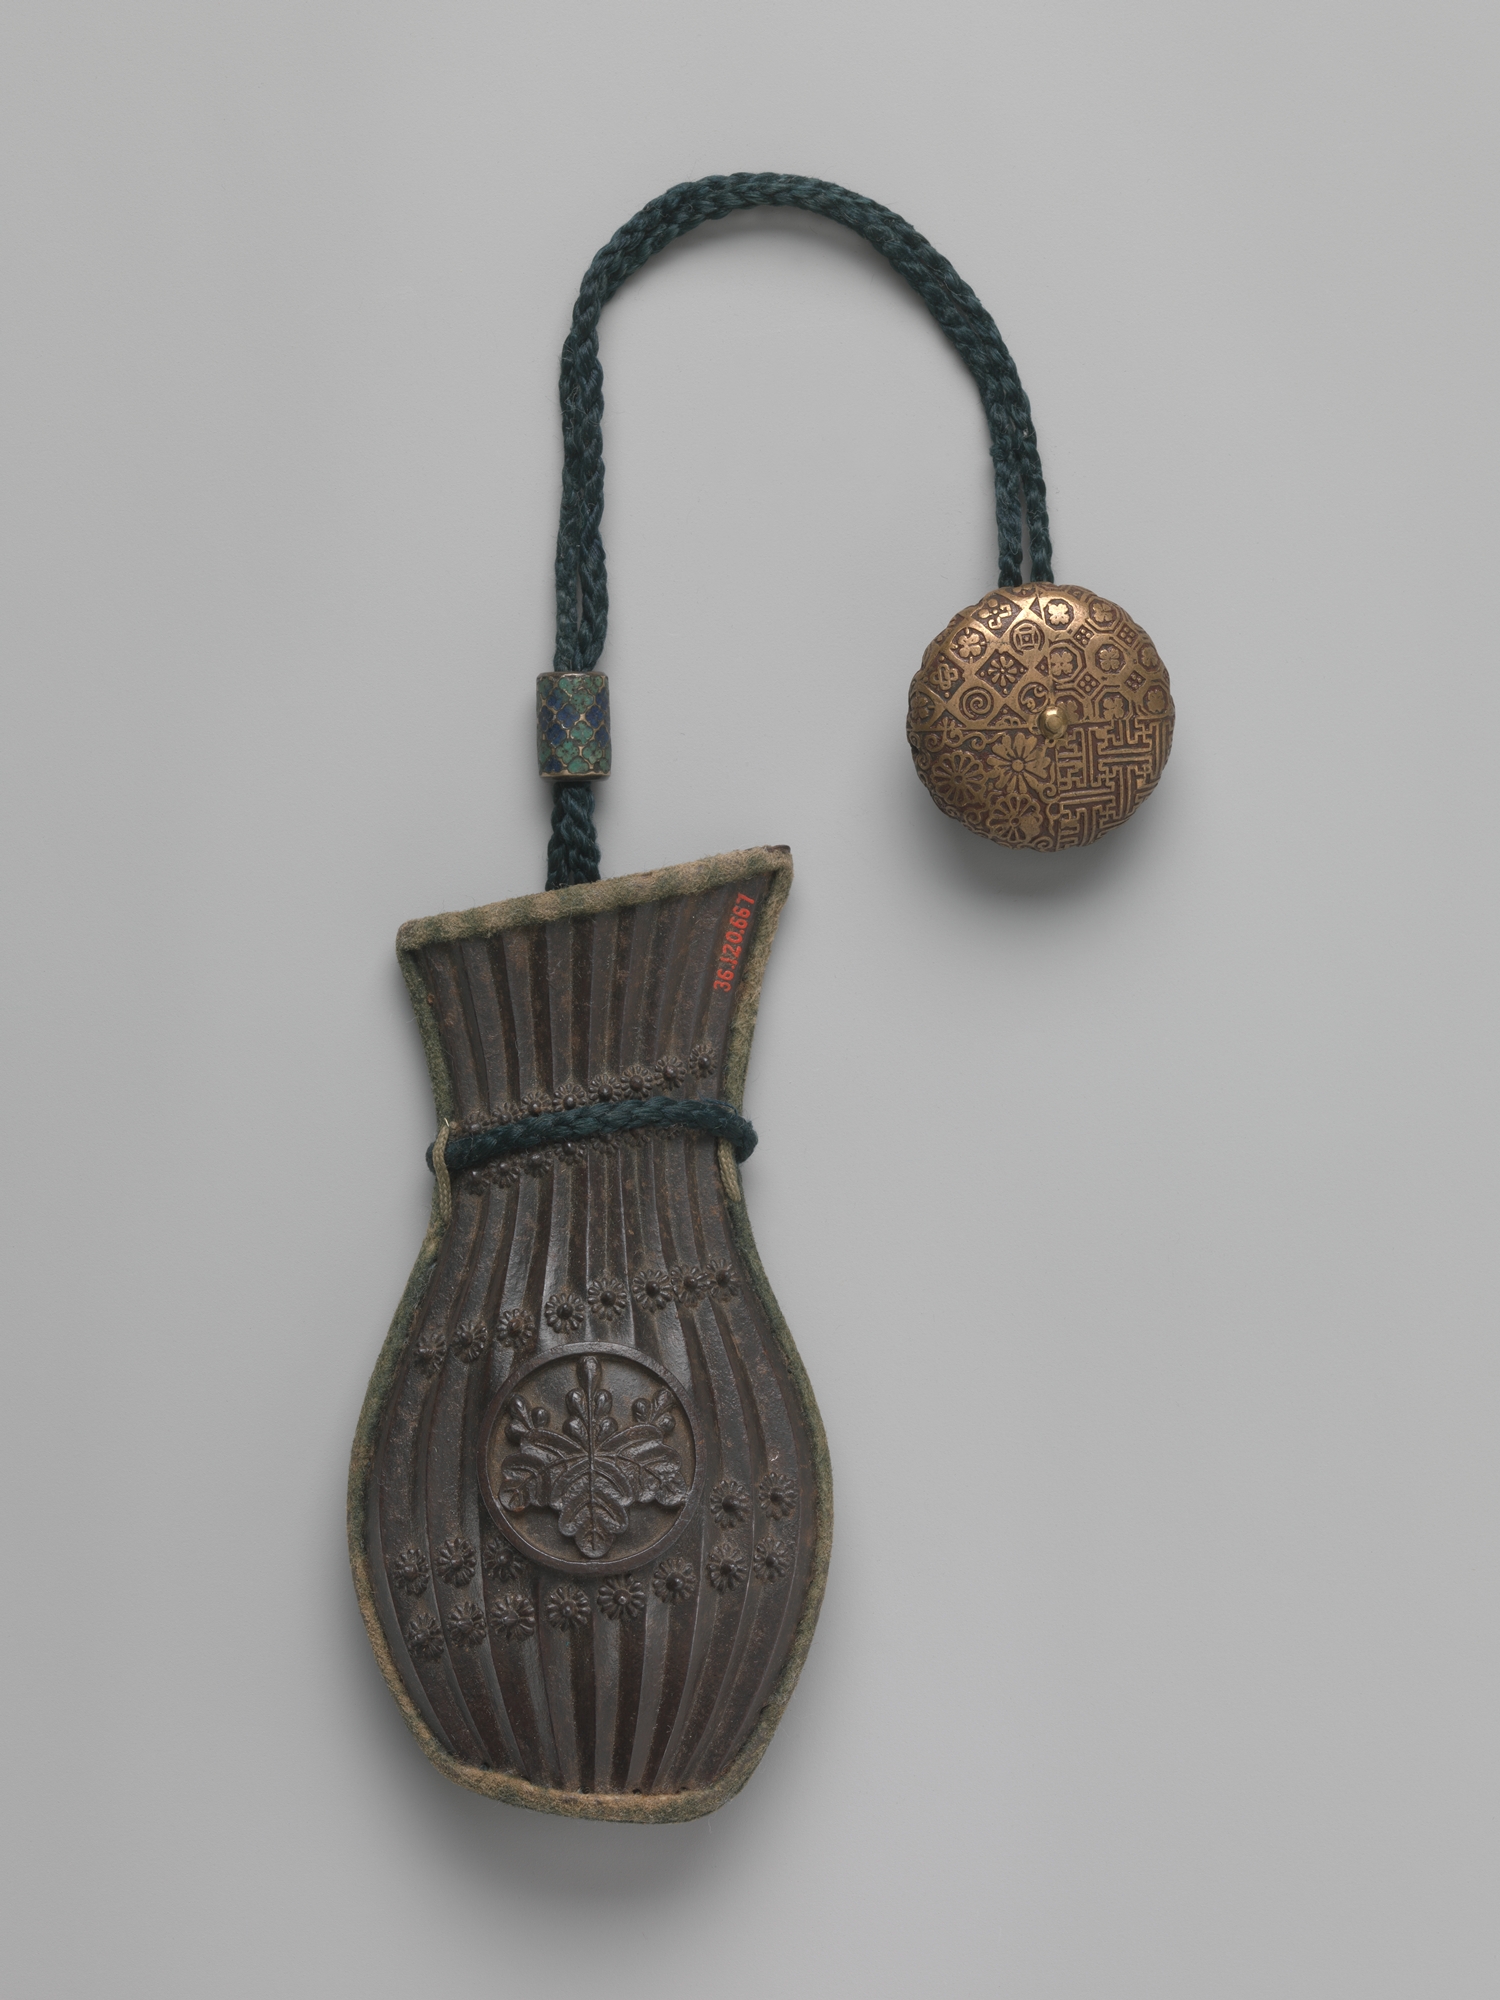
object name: tobacco pouch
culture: japanese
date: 1701-1800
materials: iron